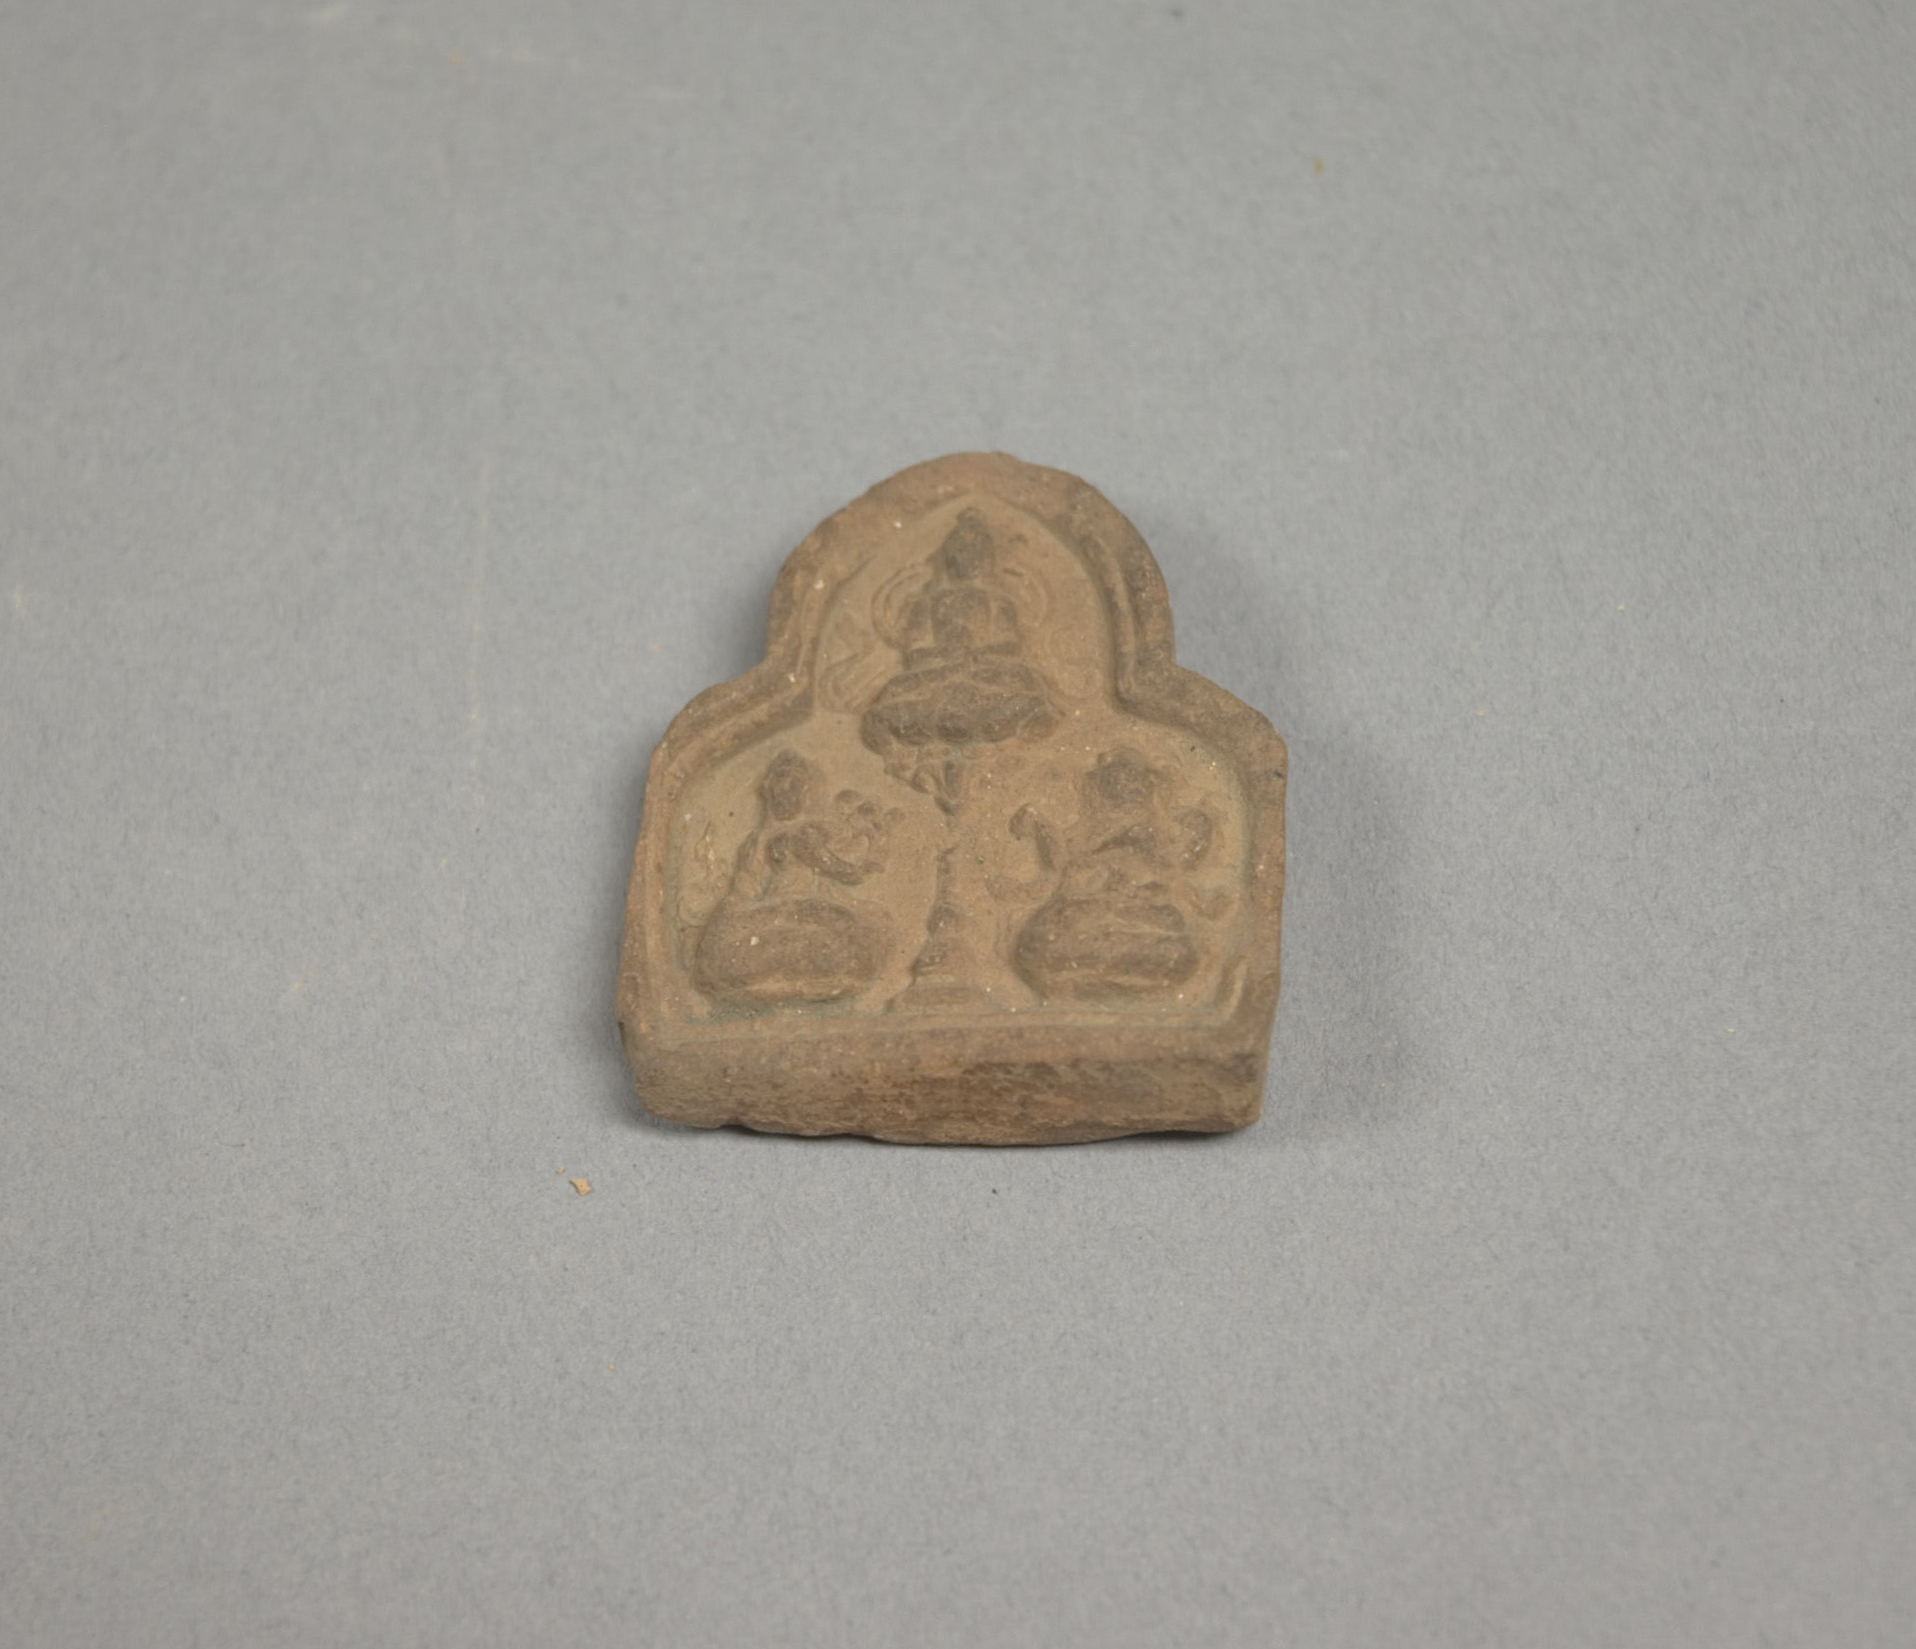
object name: votive tablet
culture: chinese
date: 1368-1644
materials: pottery